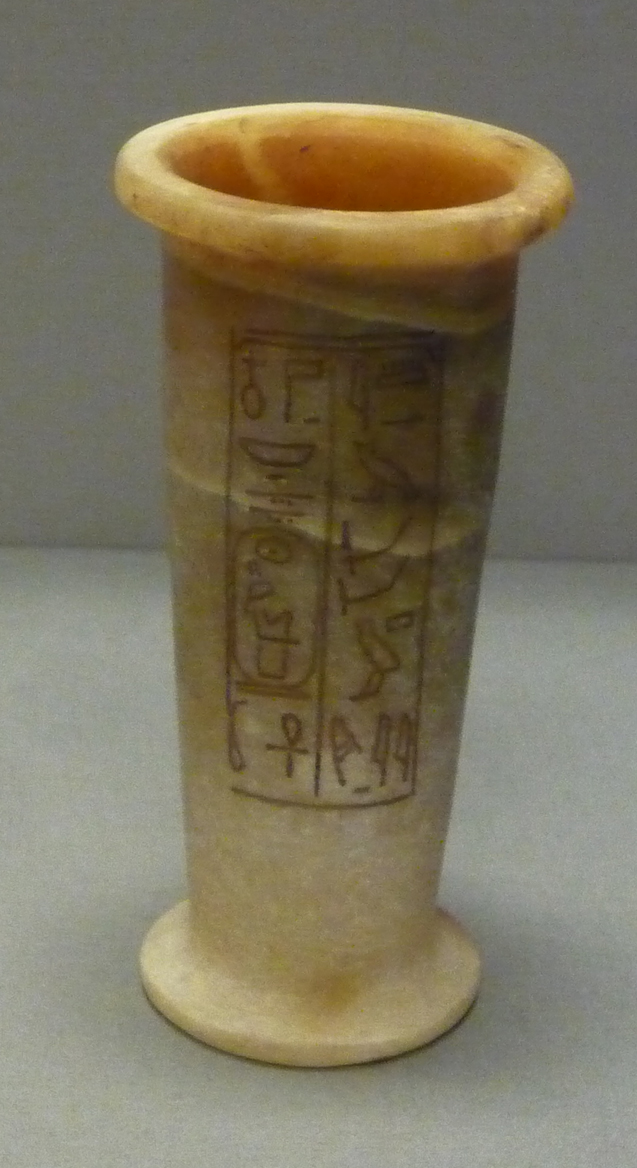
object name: ointment jar, foundation deposit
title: Ointment Jar from a Foundation Deposit of Hatshepsut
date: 1479-1458 BCE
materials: paint, stone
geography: egypt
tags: cartouches,hieroglyphs